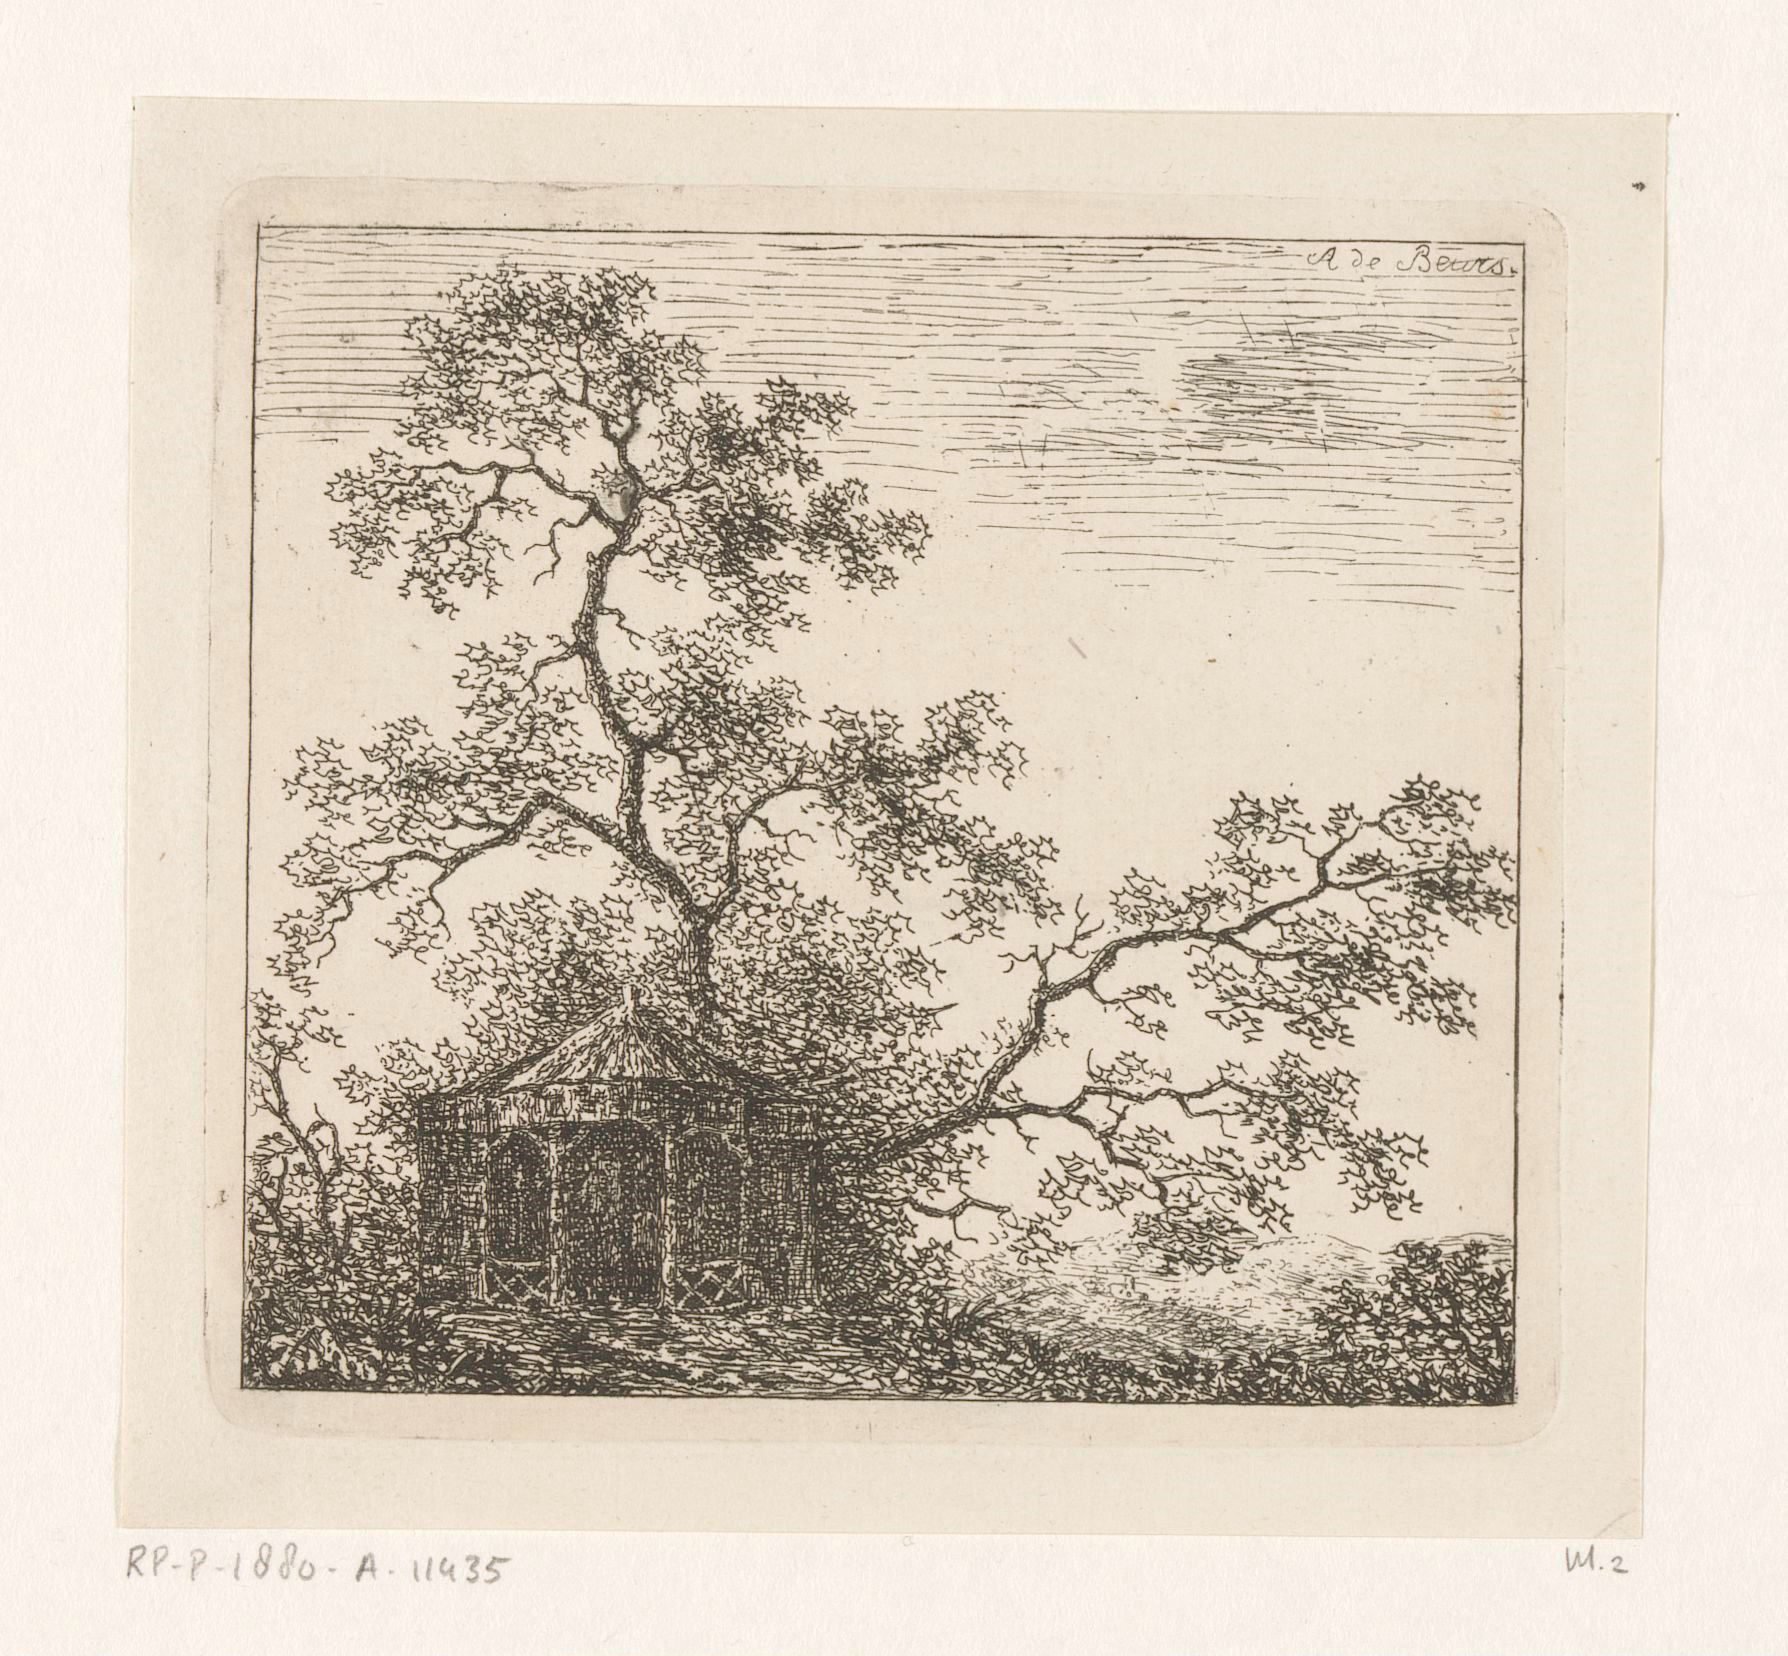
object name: print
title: Landschap met een tuinhuis voor een boom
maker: andré paul de beurs-stiermans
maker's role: print maker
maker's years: 1802-1832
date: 1812-1832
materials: paper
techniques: etching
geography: hamburg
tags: landscapes, garden buildings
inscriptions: collector's mark: Lugt 2228